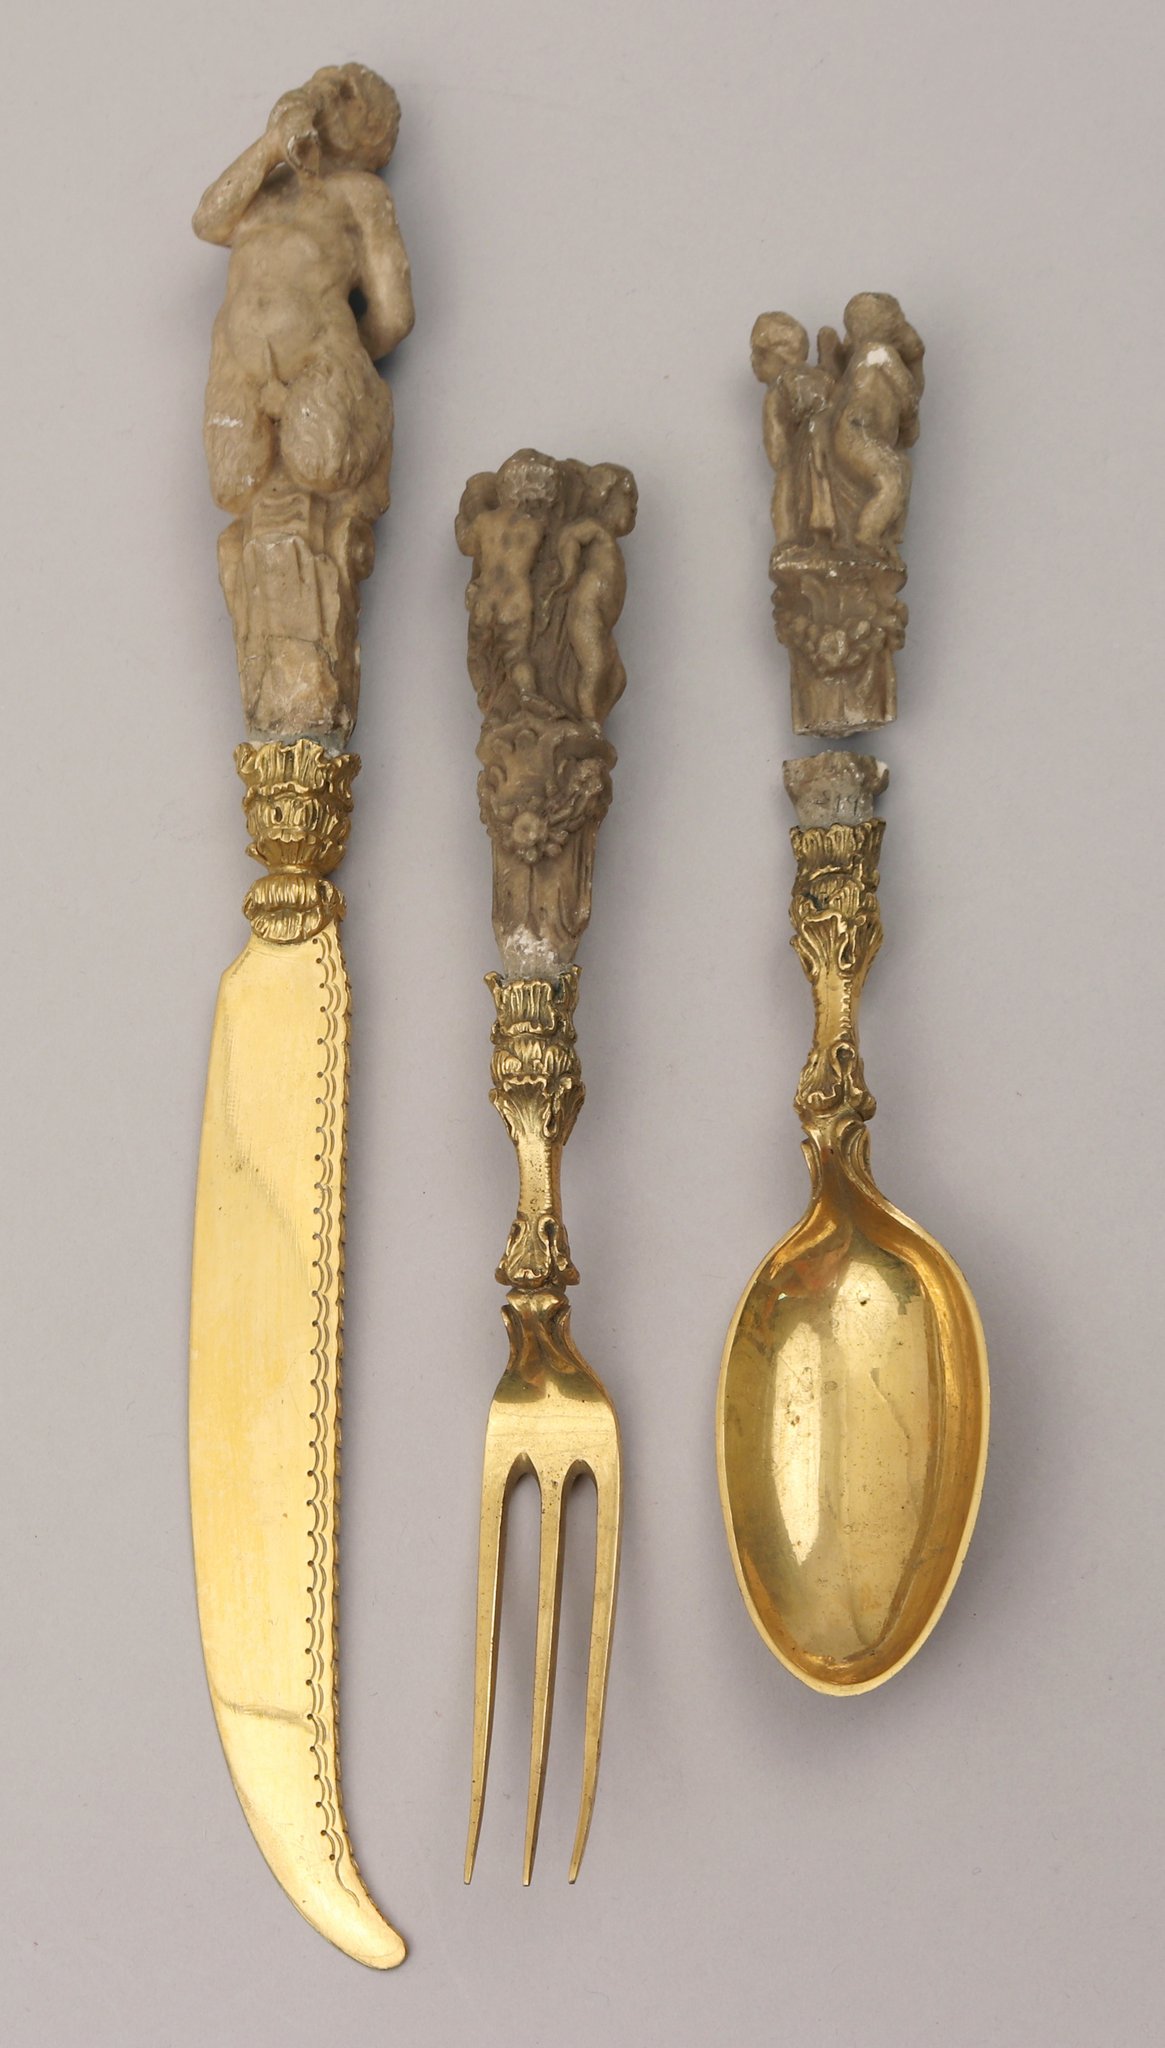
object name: knife, fork, and spoon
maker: elkington & co.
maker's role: manufacturer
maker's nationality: british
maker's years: 1829-1963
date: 1801-1900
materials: metal, silver